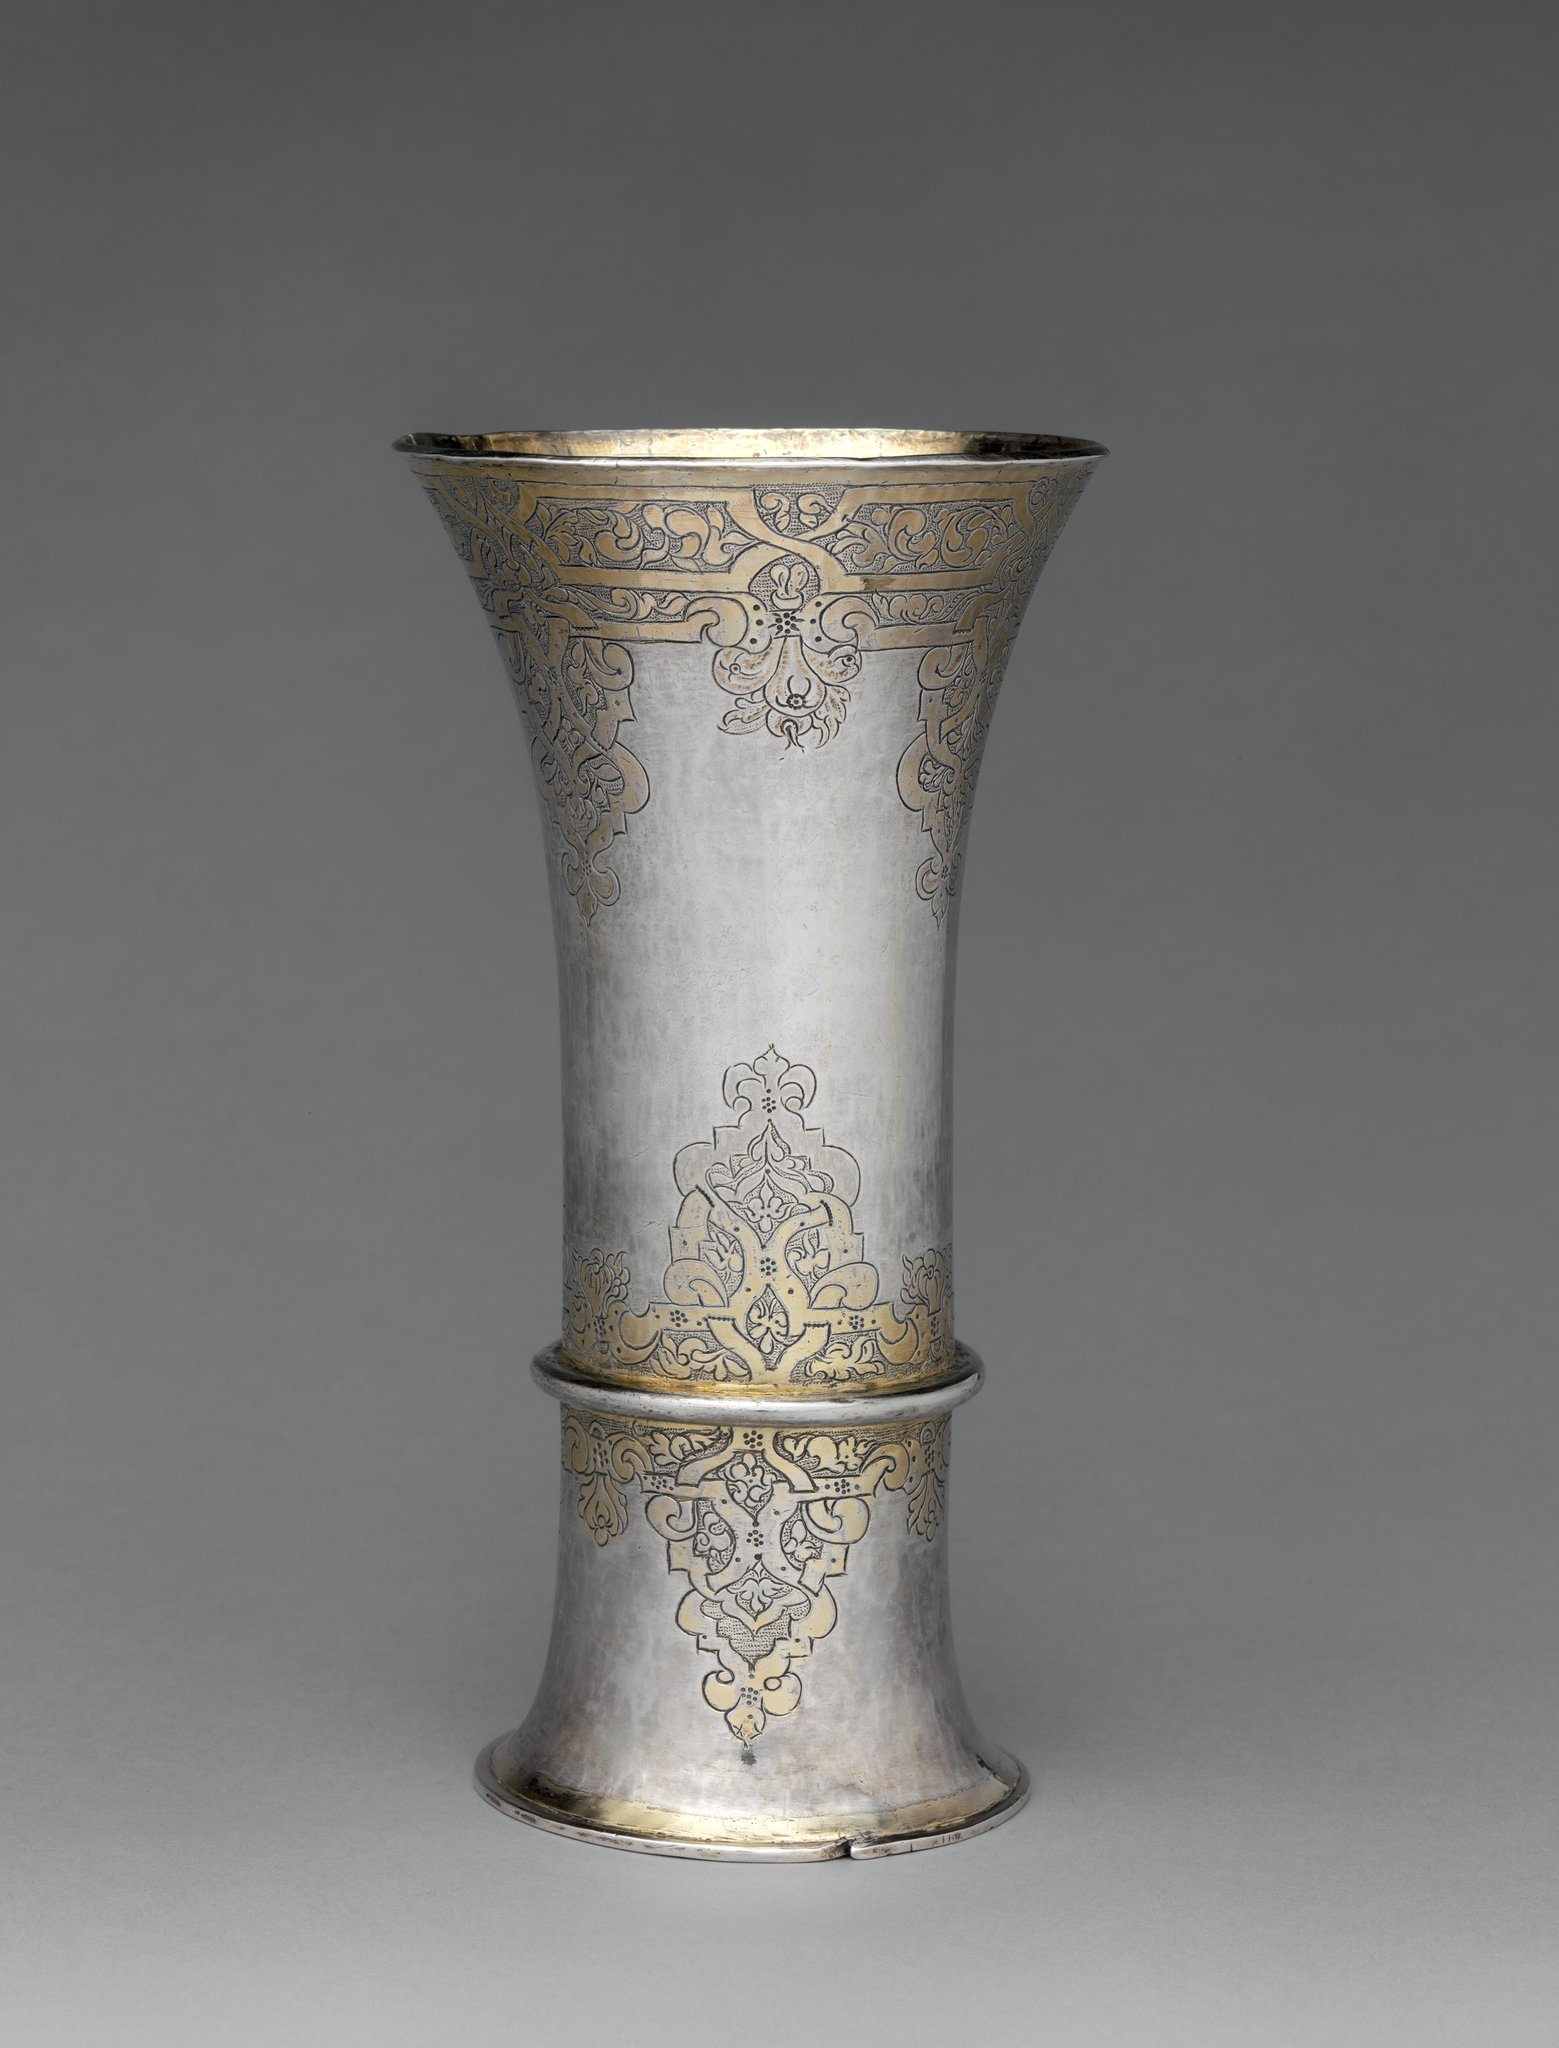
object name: footed beaker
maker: paulus brölfft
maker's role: maker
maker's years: 1525-1625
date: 1551-1600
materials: silver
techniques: gilding